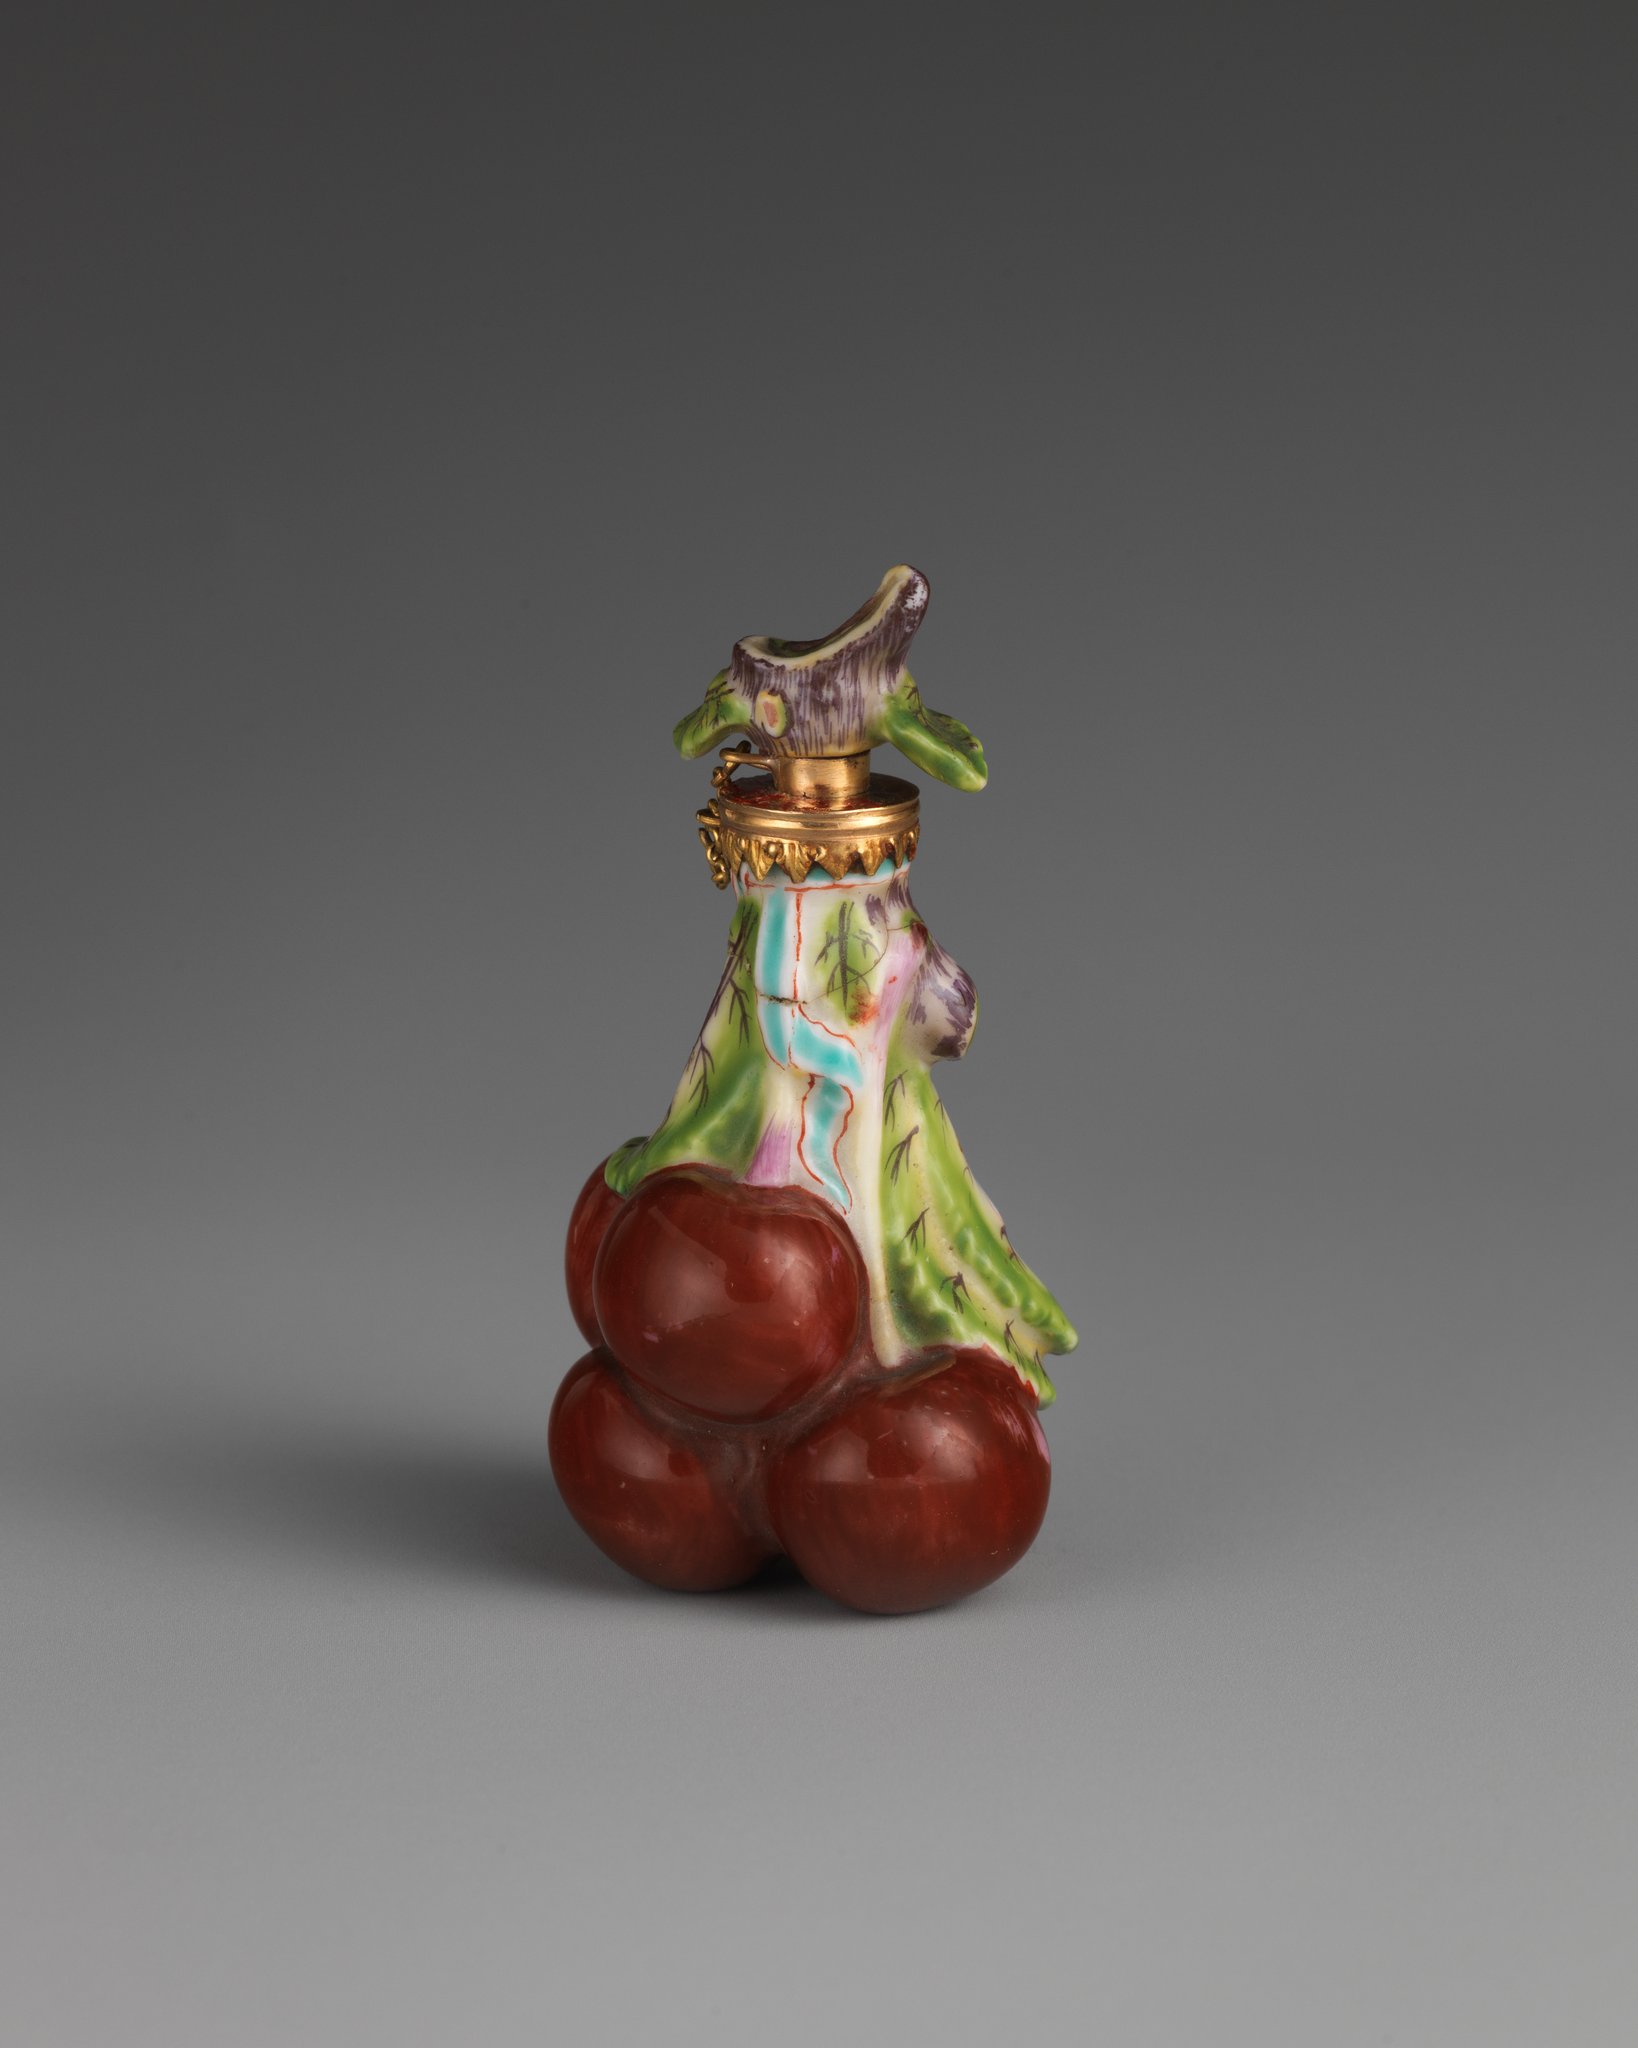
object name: scent bottle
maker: chelsea porcelain manufactory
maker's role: factory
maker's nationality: british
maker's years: 1744-1784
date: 1760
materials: soft paste porcelain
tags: fruit